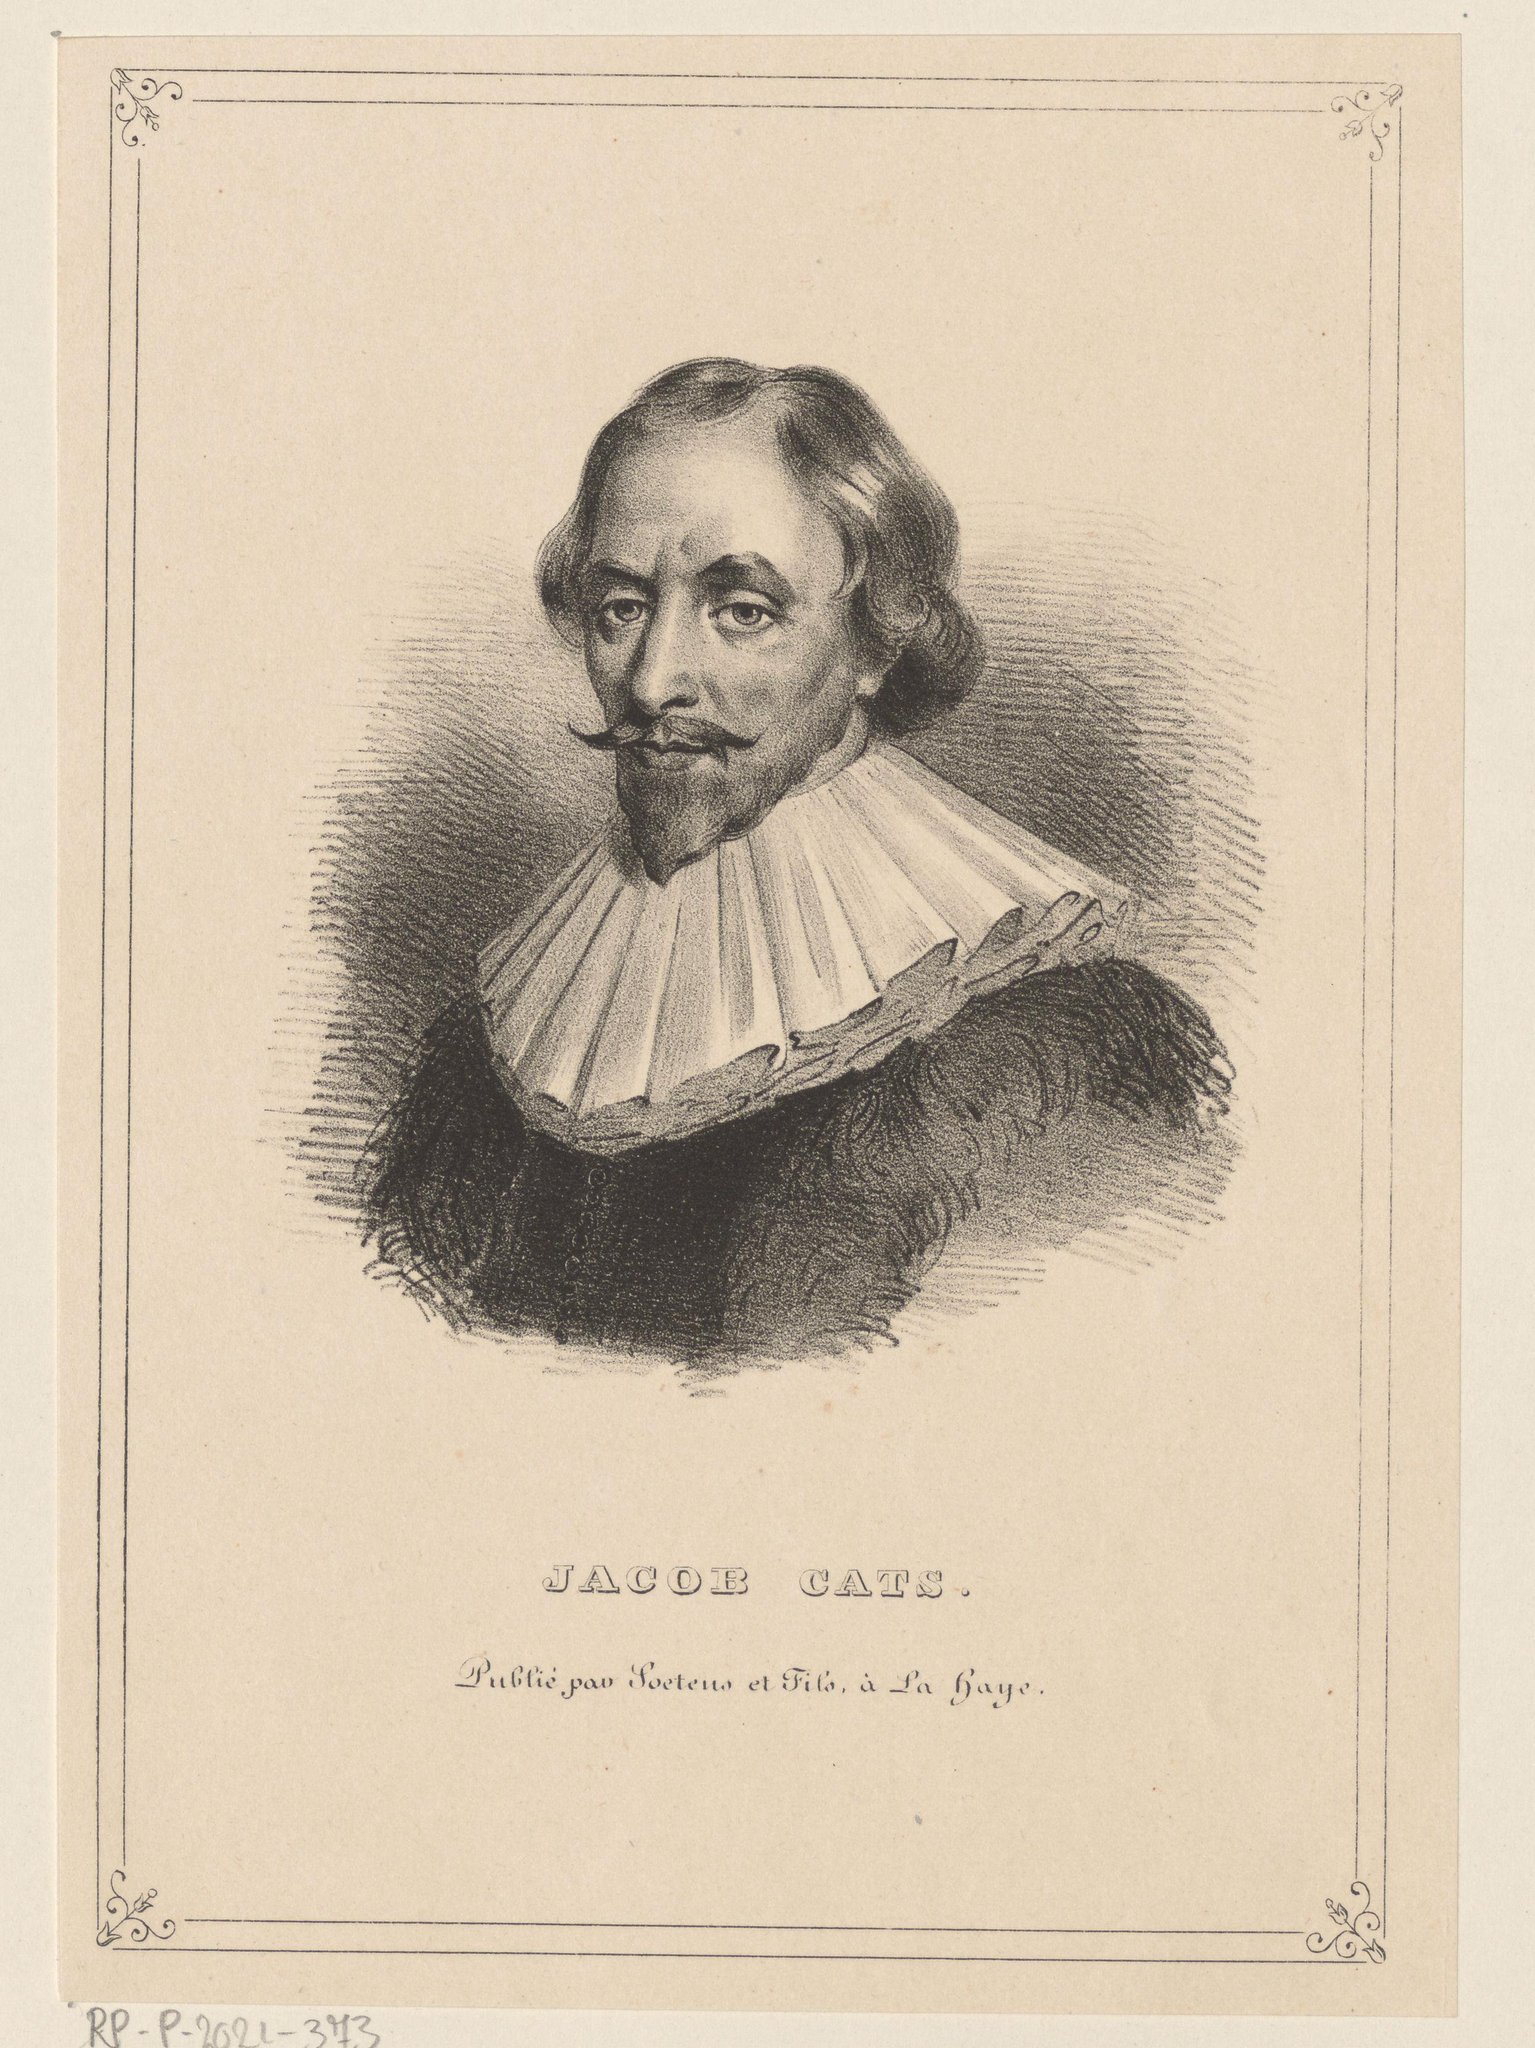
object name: print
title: Portret van Jacob Cats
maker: Anonymous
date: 1837-1840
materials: paper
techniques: lithograph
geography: the hague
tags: the hague, jacob cats (1577-1660), historical persons